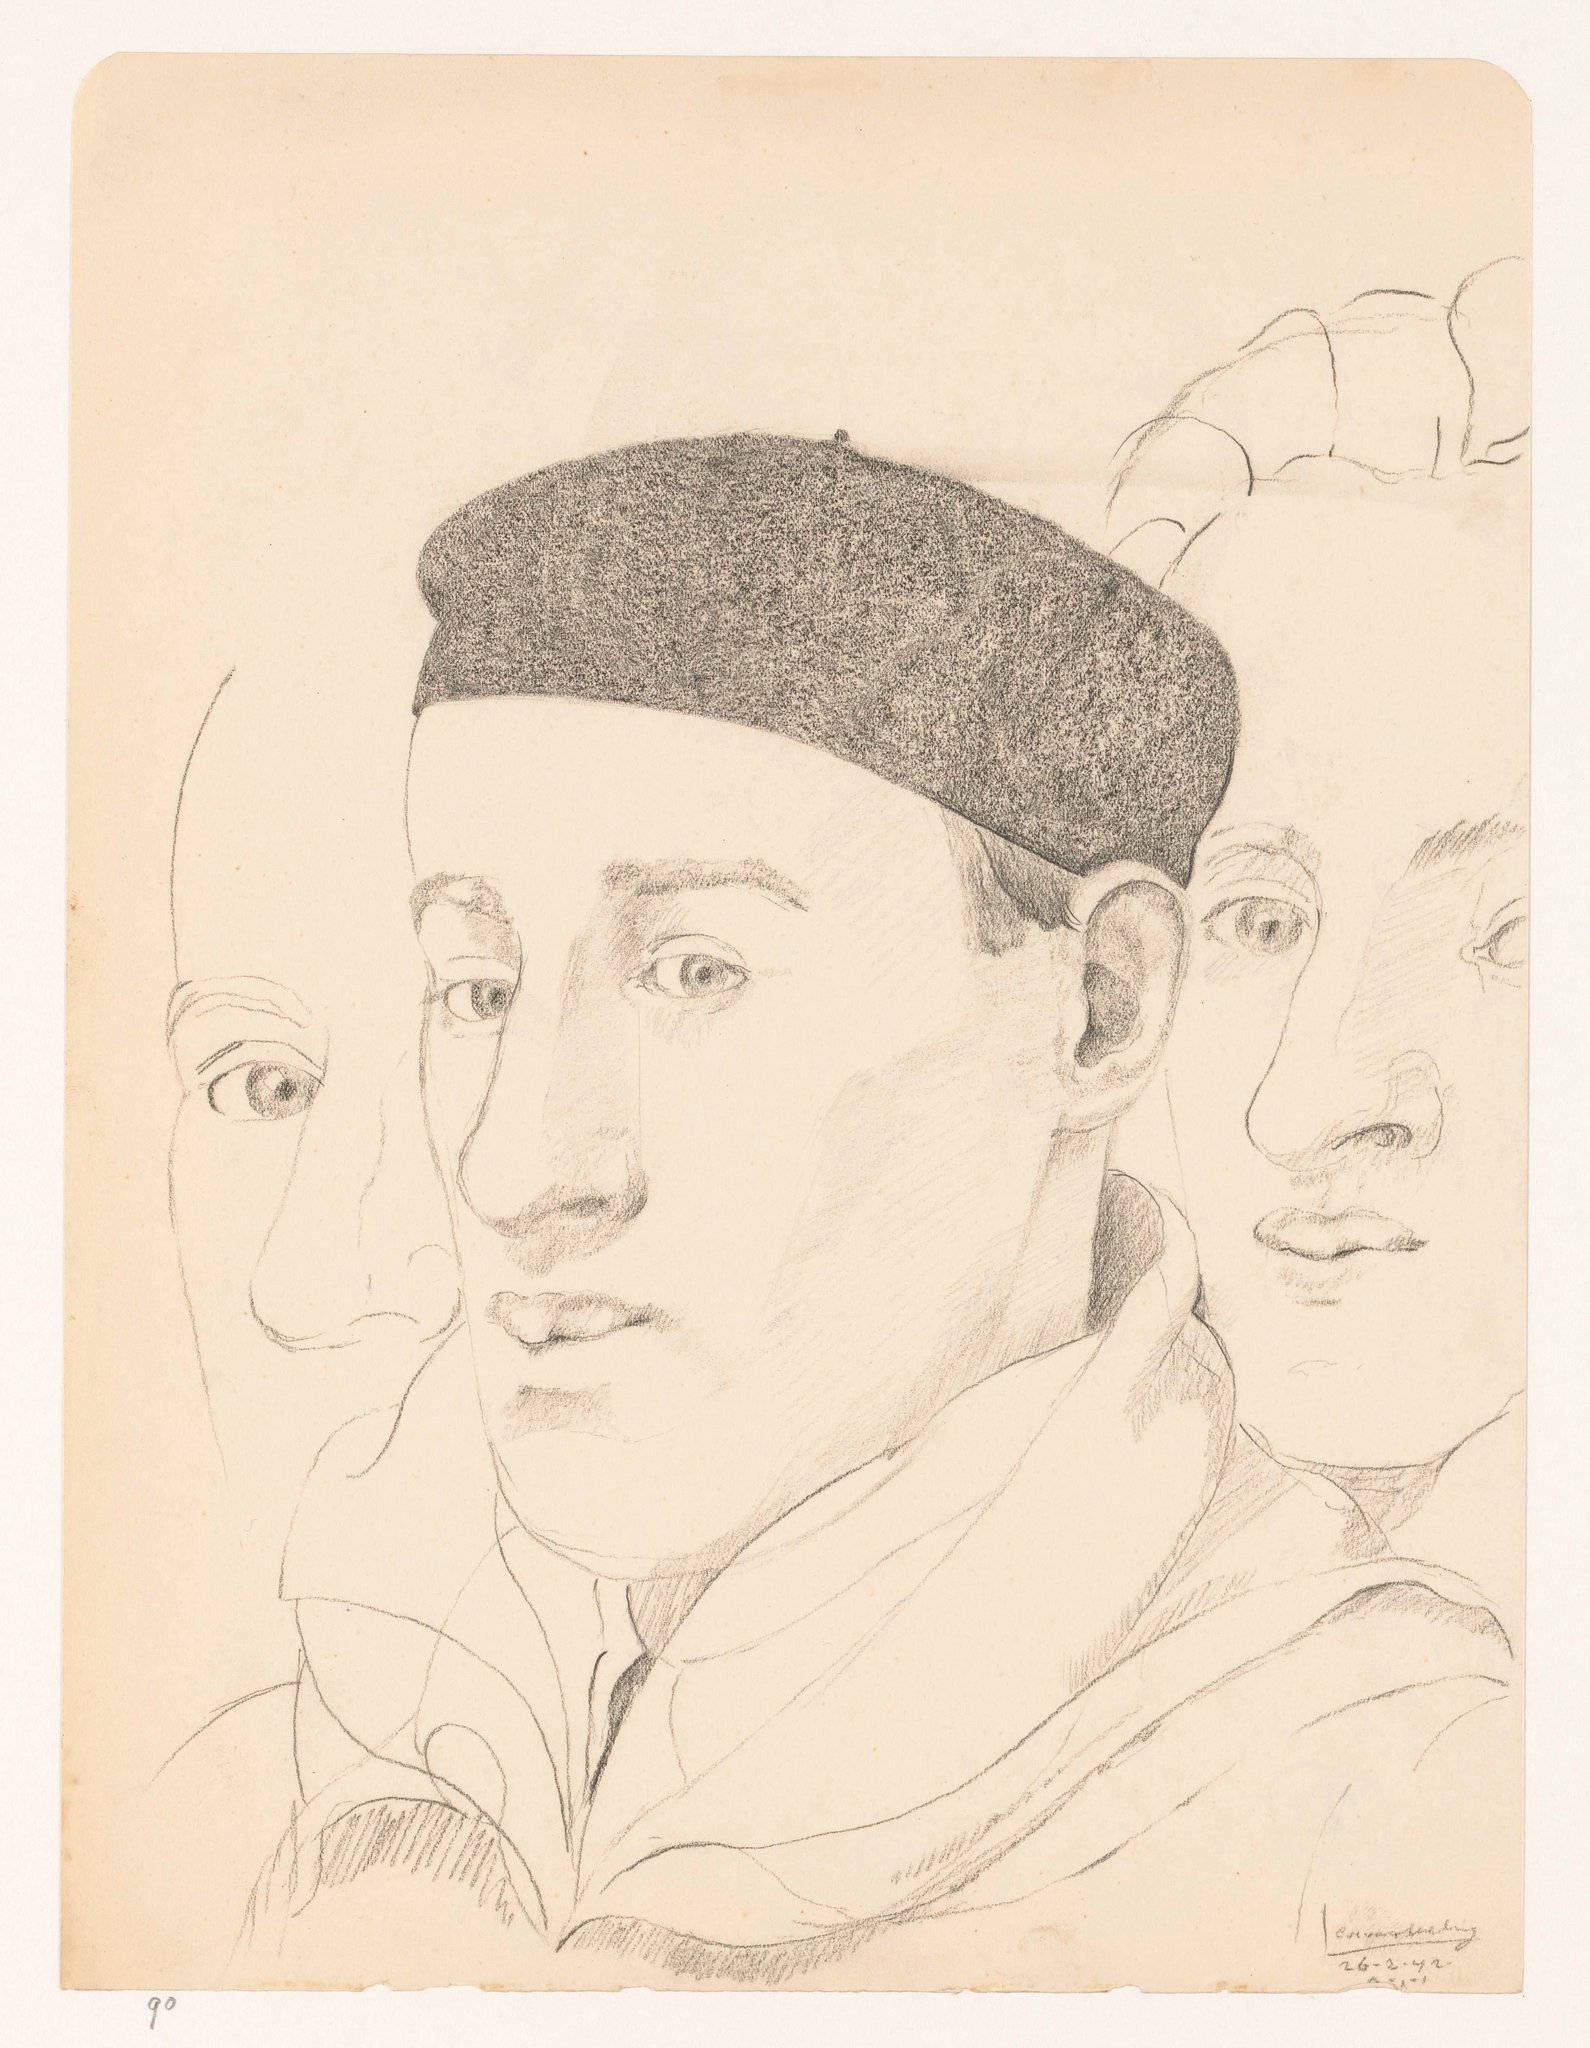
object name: drawing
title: Zelfportretten van Cor van Teeseling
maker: cor van teeseling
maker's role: draughtsman, sculptor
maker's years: 1915-1942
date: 1942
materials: paper, pencil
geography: weteringschans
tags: amsterdam, draughtsman, sculptor, cor van teeseling, historical persons, prisoner in cell or locked place, portrait, self-portrait of draughtsman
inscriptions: date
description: Blad met 3 zelfportretten van Cor van Teeseling: B-1-1, 26 februari.